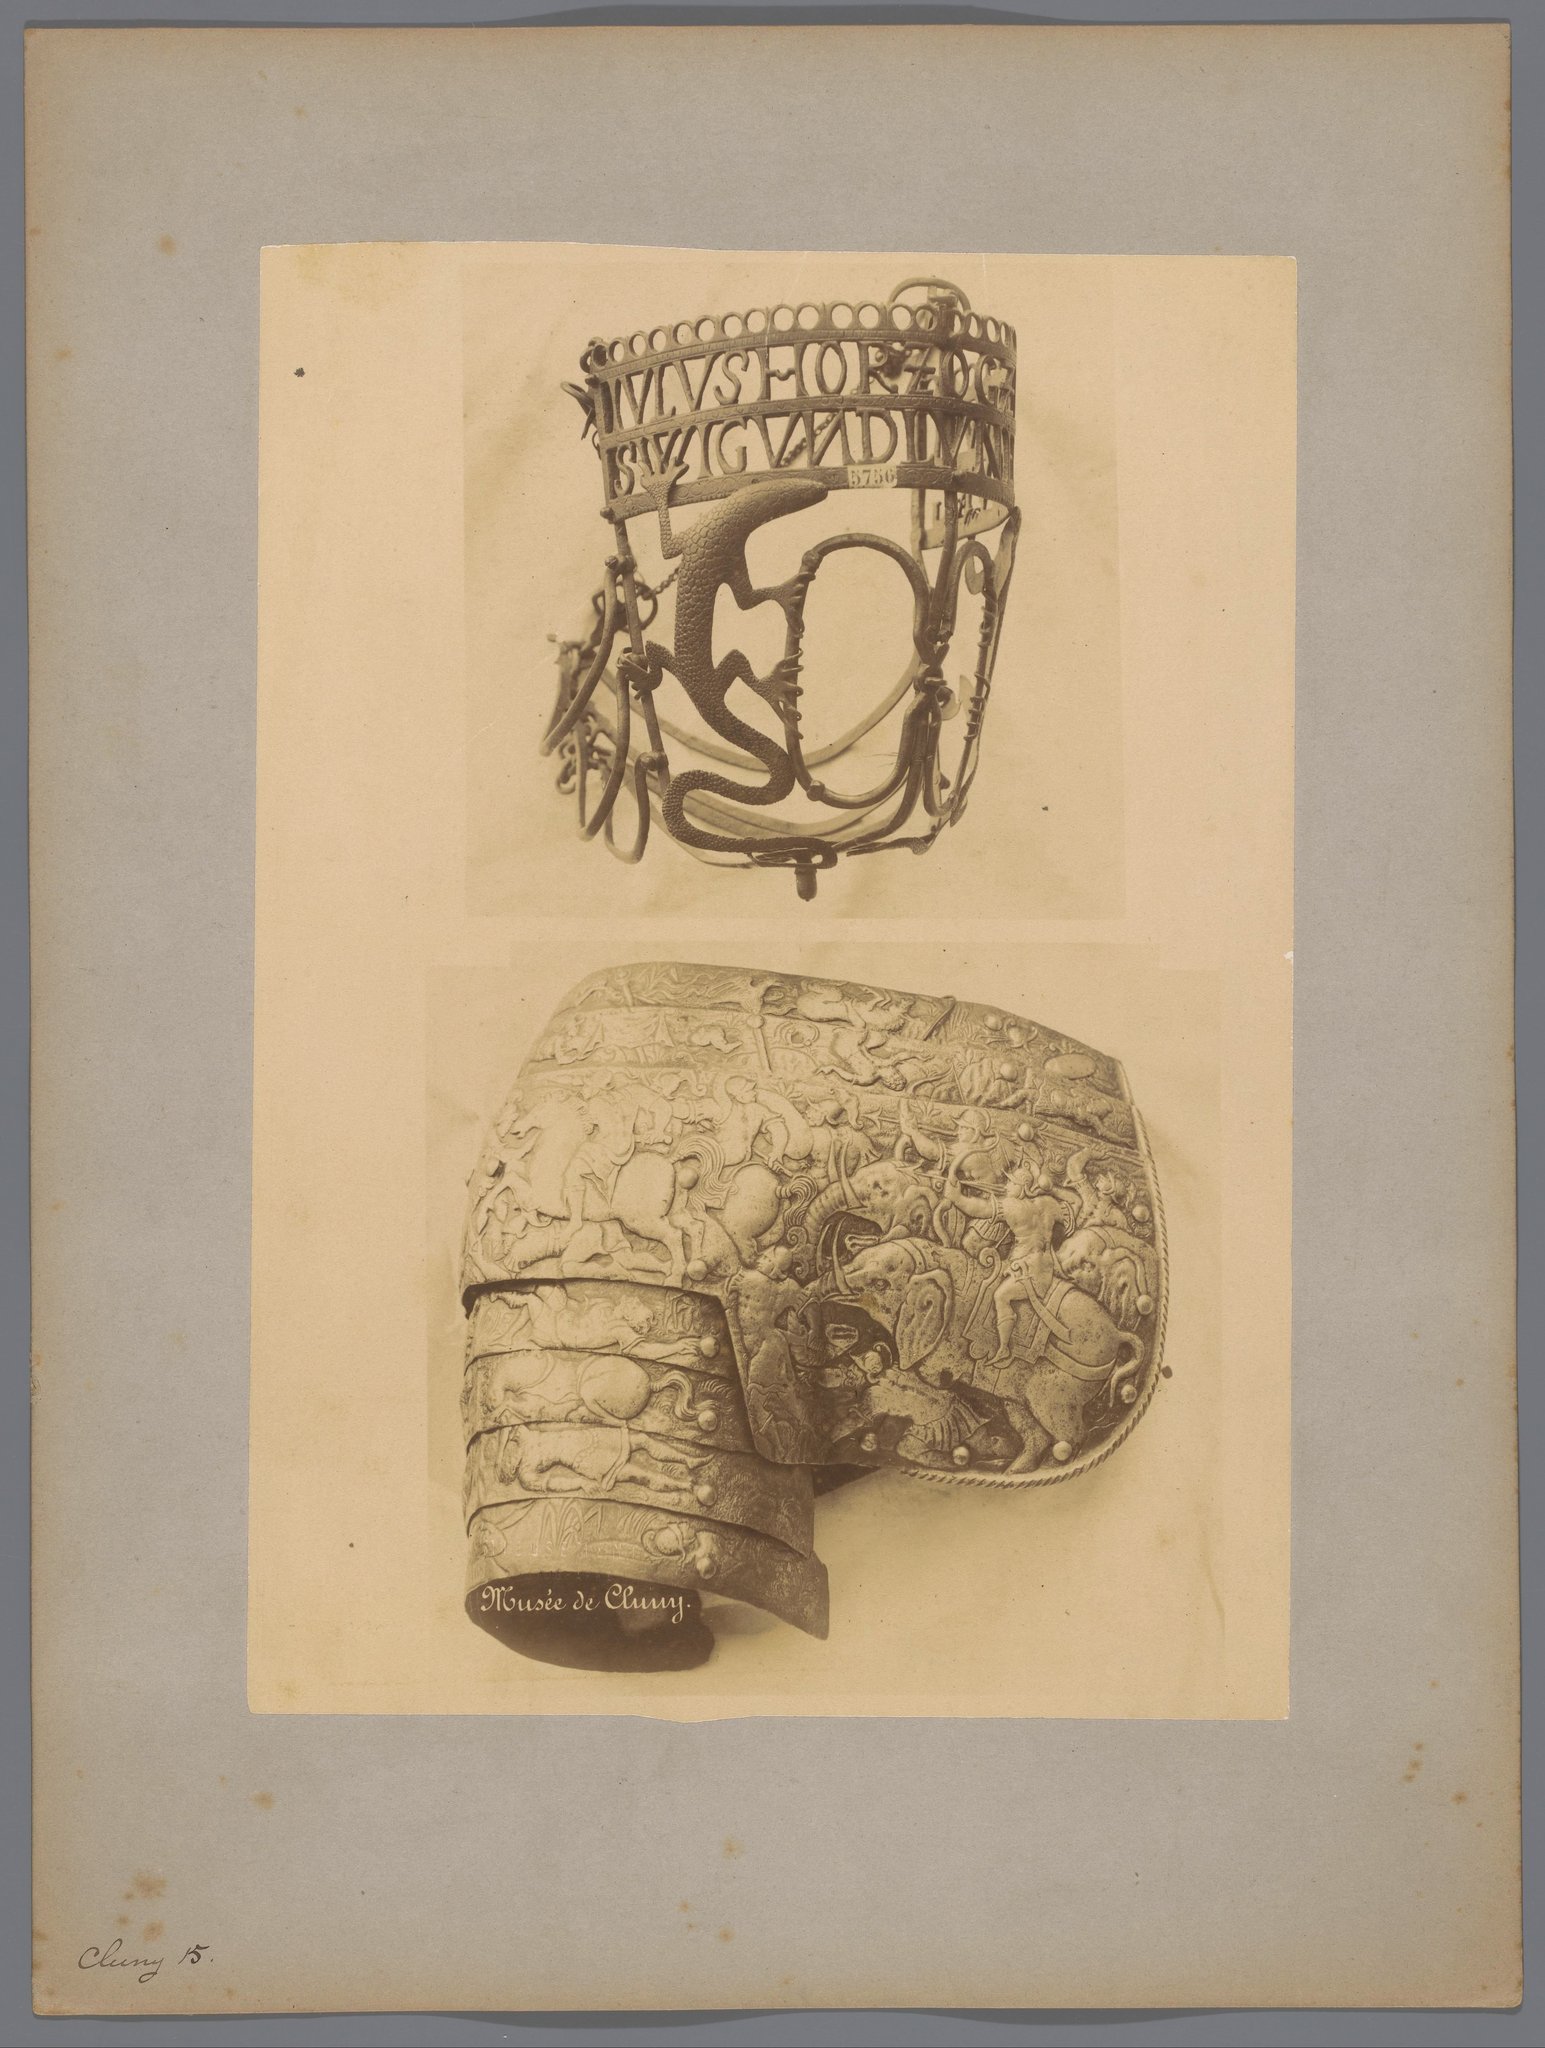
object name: photograph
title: Schouderstuk van een harnas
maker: séraphin-médéric mieusement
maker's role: fotograaf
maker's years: 1840-1905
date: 1850-1900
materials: cardboard, photographic support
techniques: albumen print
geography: paris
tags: harness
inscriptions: workshop stamp: ‘Mieusement/ Photographe’, collector's mark: ‘Rijks-normaalschool voor teekenonderwijzers Amsterdam’ Lugt 3937, number: ‘Cluny 15’